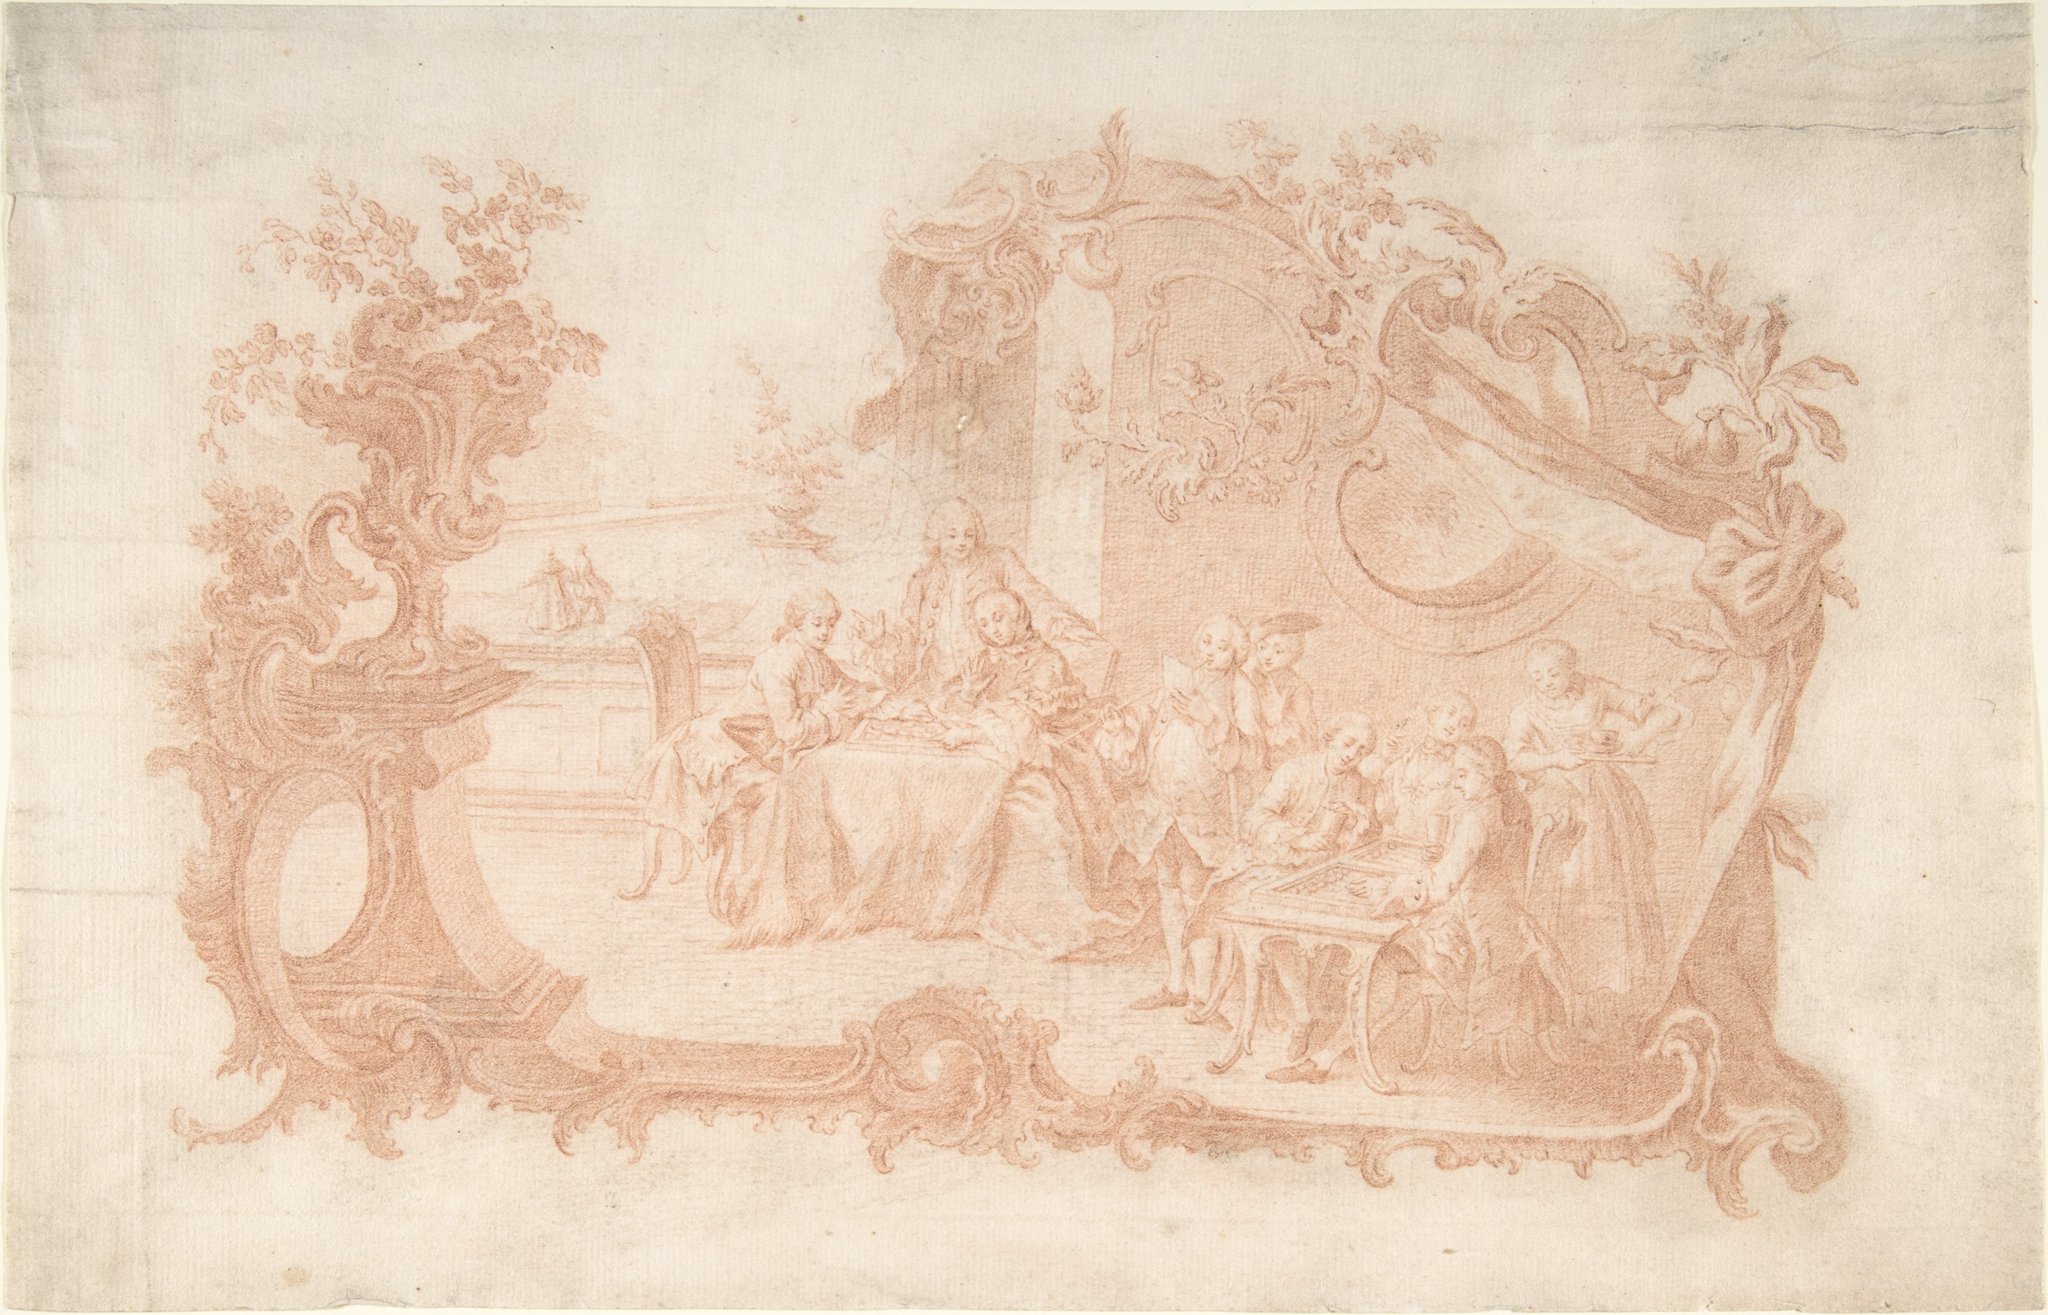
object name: drawing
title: Game of Backgammon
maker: johann esaias nilson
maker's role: artist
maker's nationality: german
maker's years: 1721-1788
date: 1741-1788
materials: chalk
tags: men,women,games